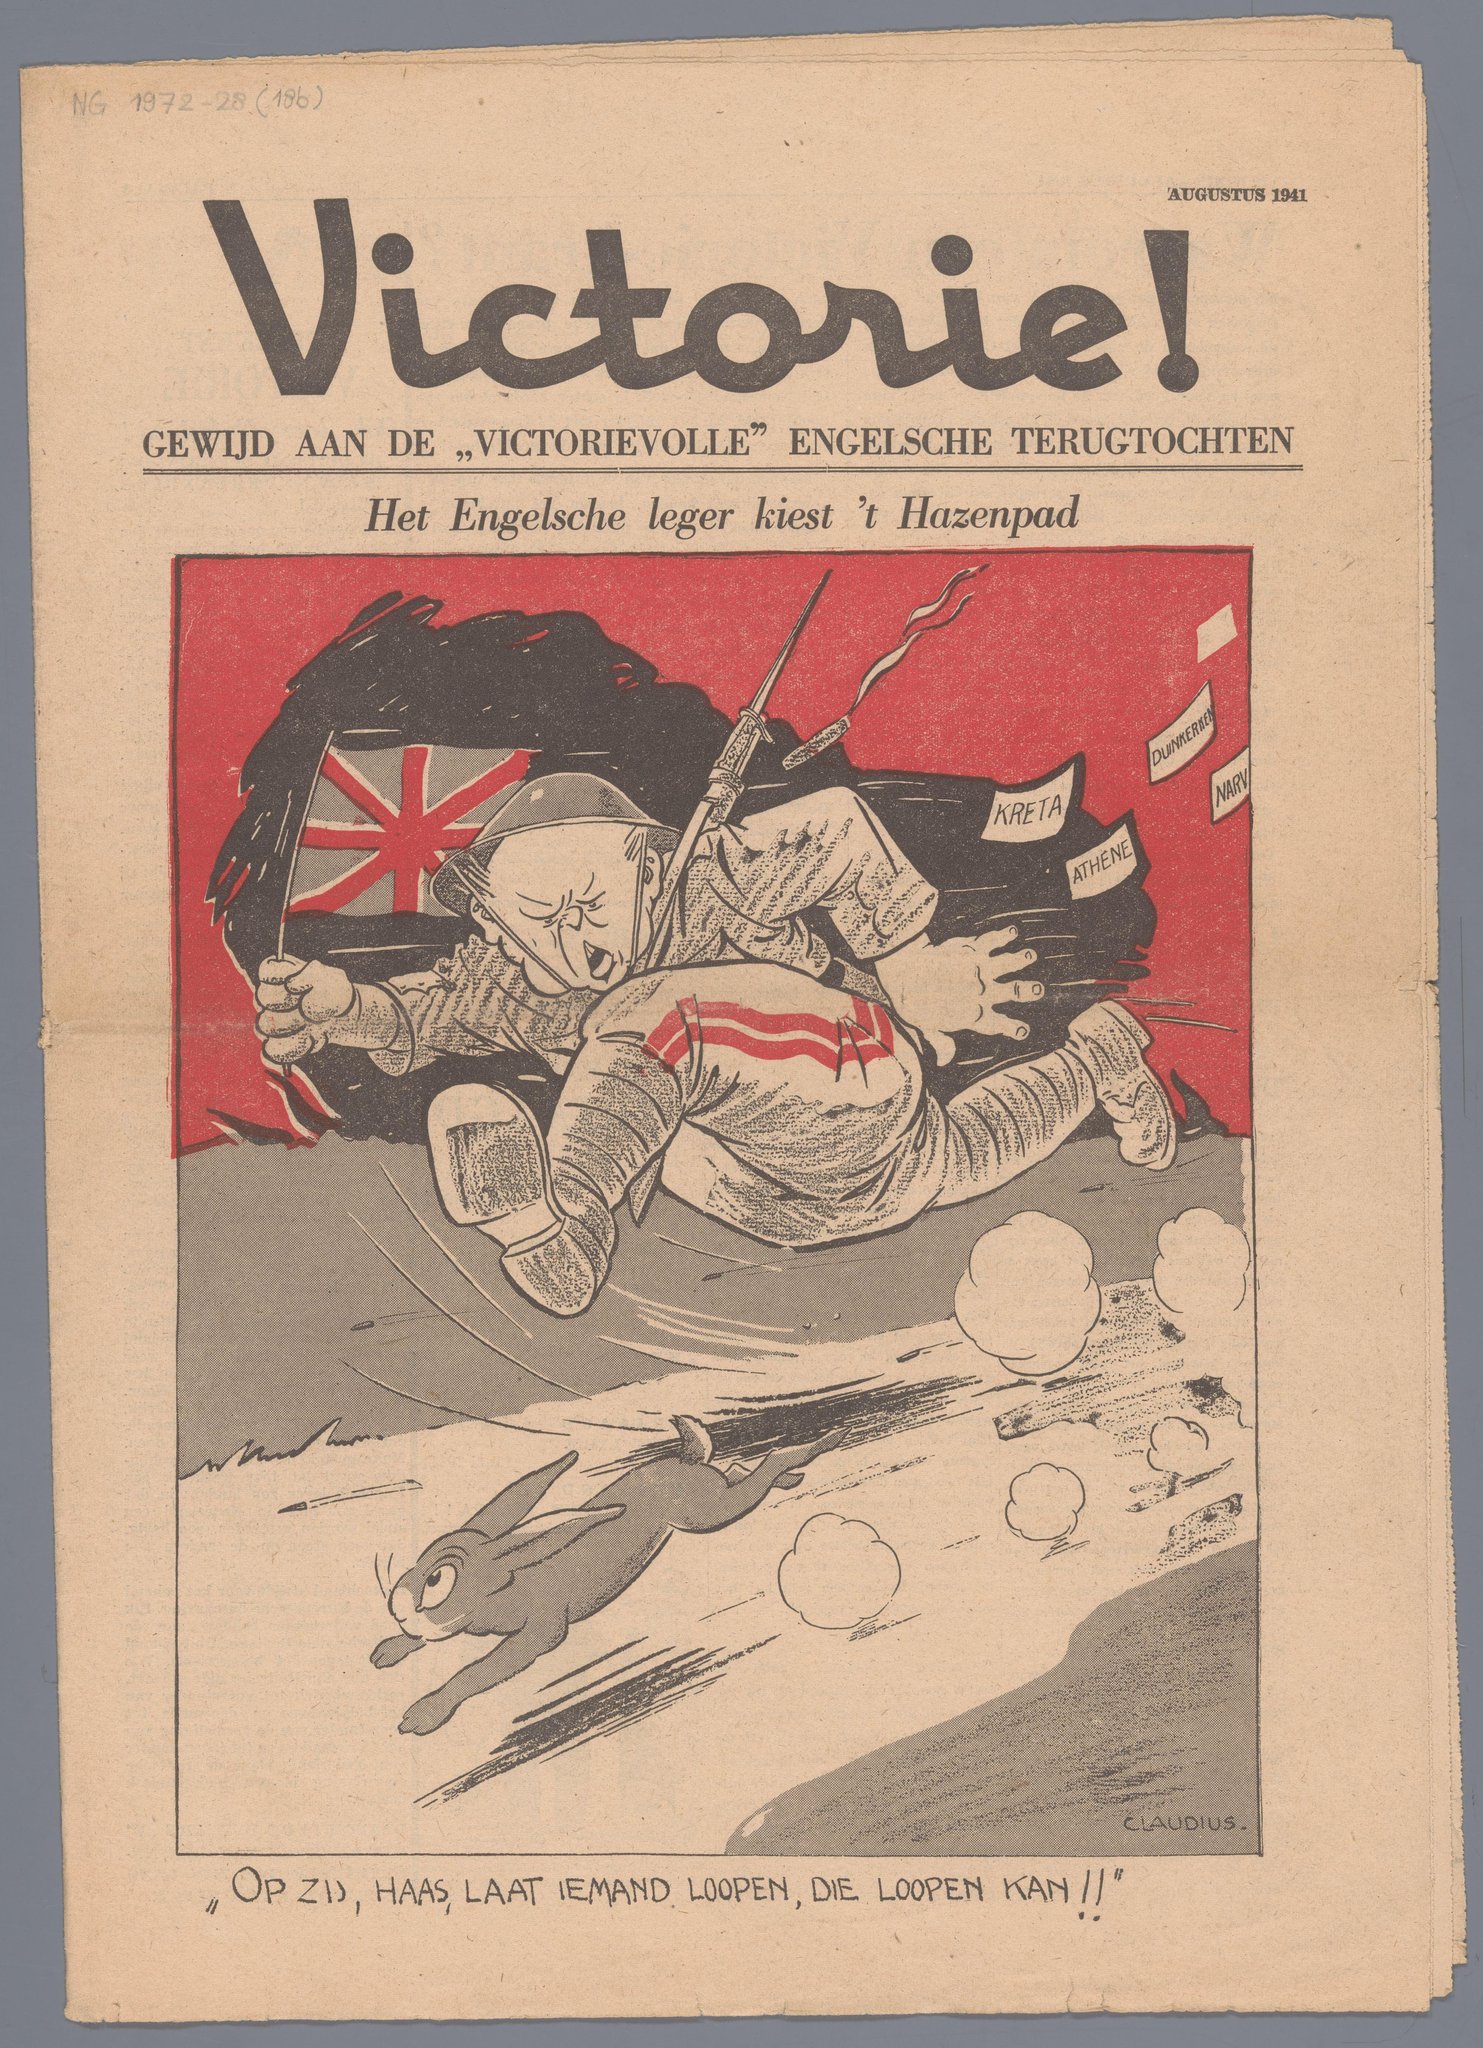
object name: newspaper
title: Victorie!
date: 1908-1941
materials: paper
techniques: printing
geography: the hague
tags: netherlands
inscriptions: date